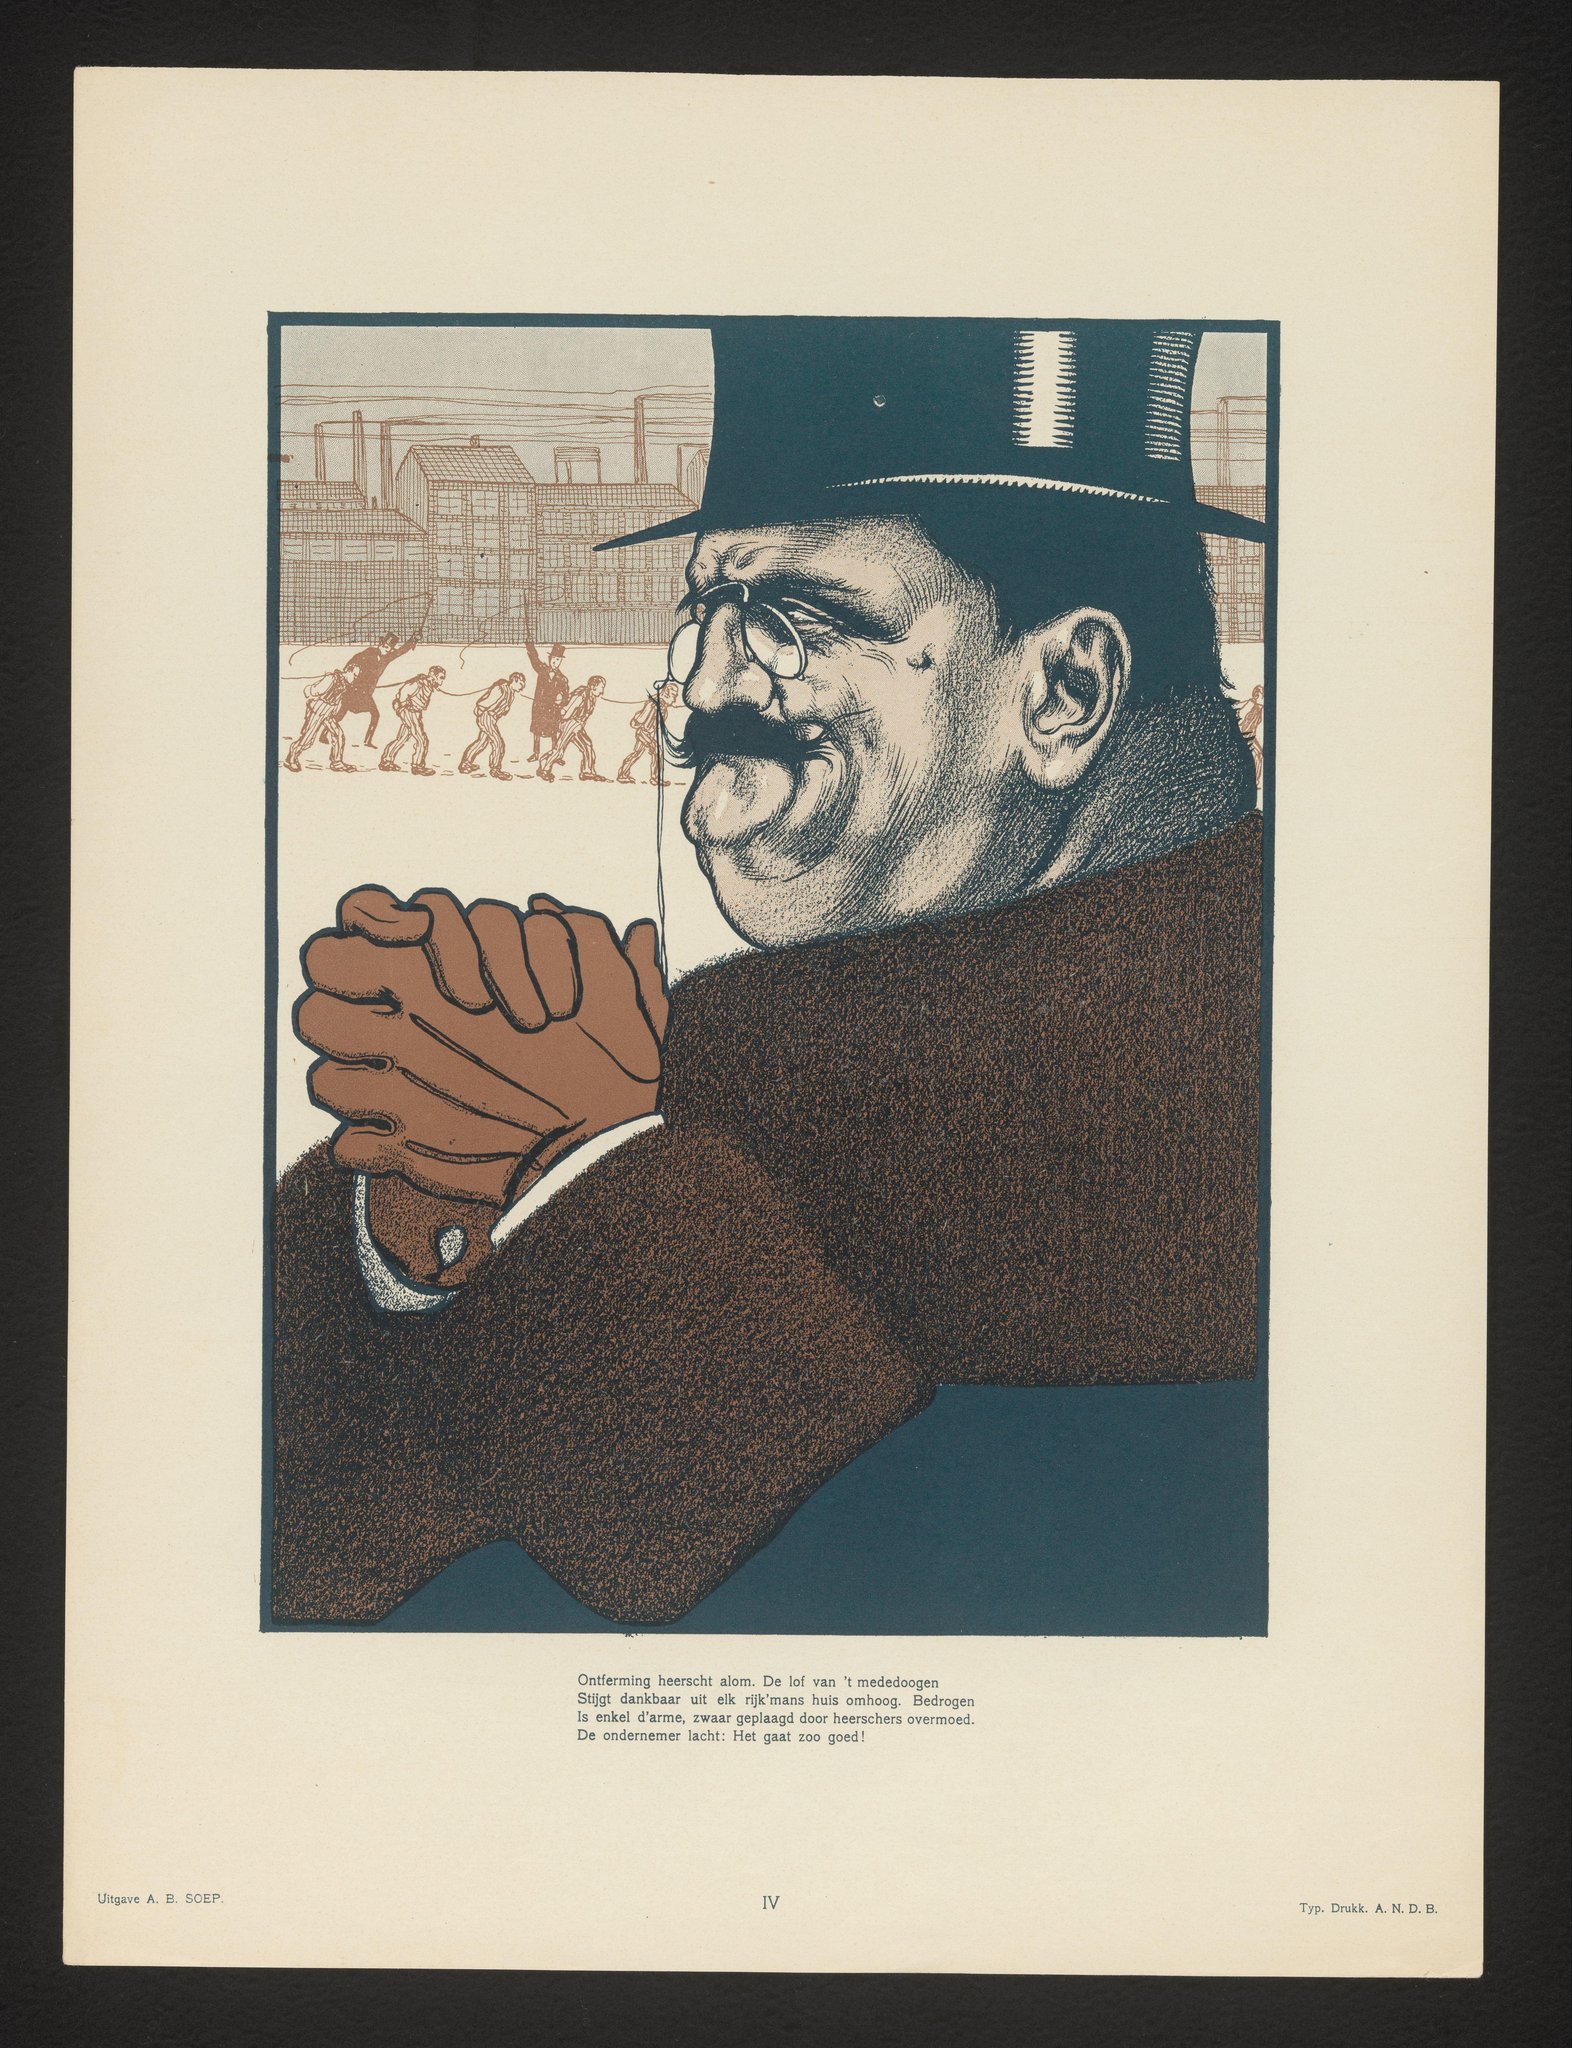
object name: print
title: De ondernemer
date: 1905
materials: paper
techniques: autotype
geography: amsterdam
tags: abraham kuyper, director, boss (in modern industry), the rich, working class, labourers, political caricatures and satires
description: De lachende ondernemer (Abraham Kuyper) wrijft in zijn handen. Op de achtergrond worden geketende arbeiders met zwepen opgejaagd naar de fabrieken. Met vierregelig onderschrift. Onderdeel van de prentserie 'Onder Zwart Regime'.